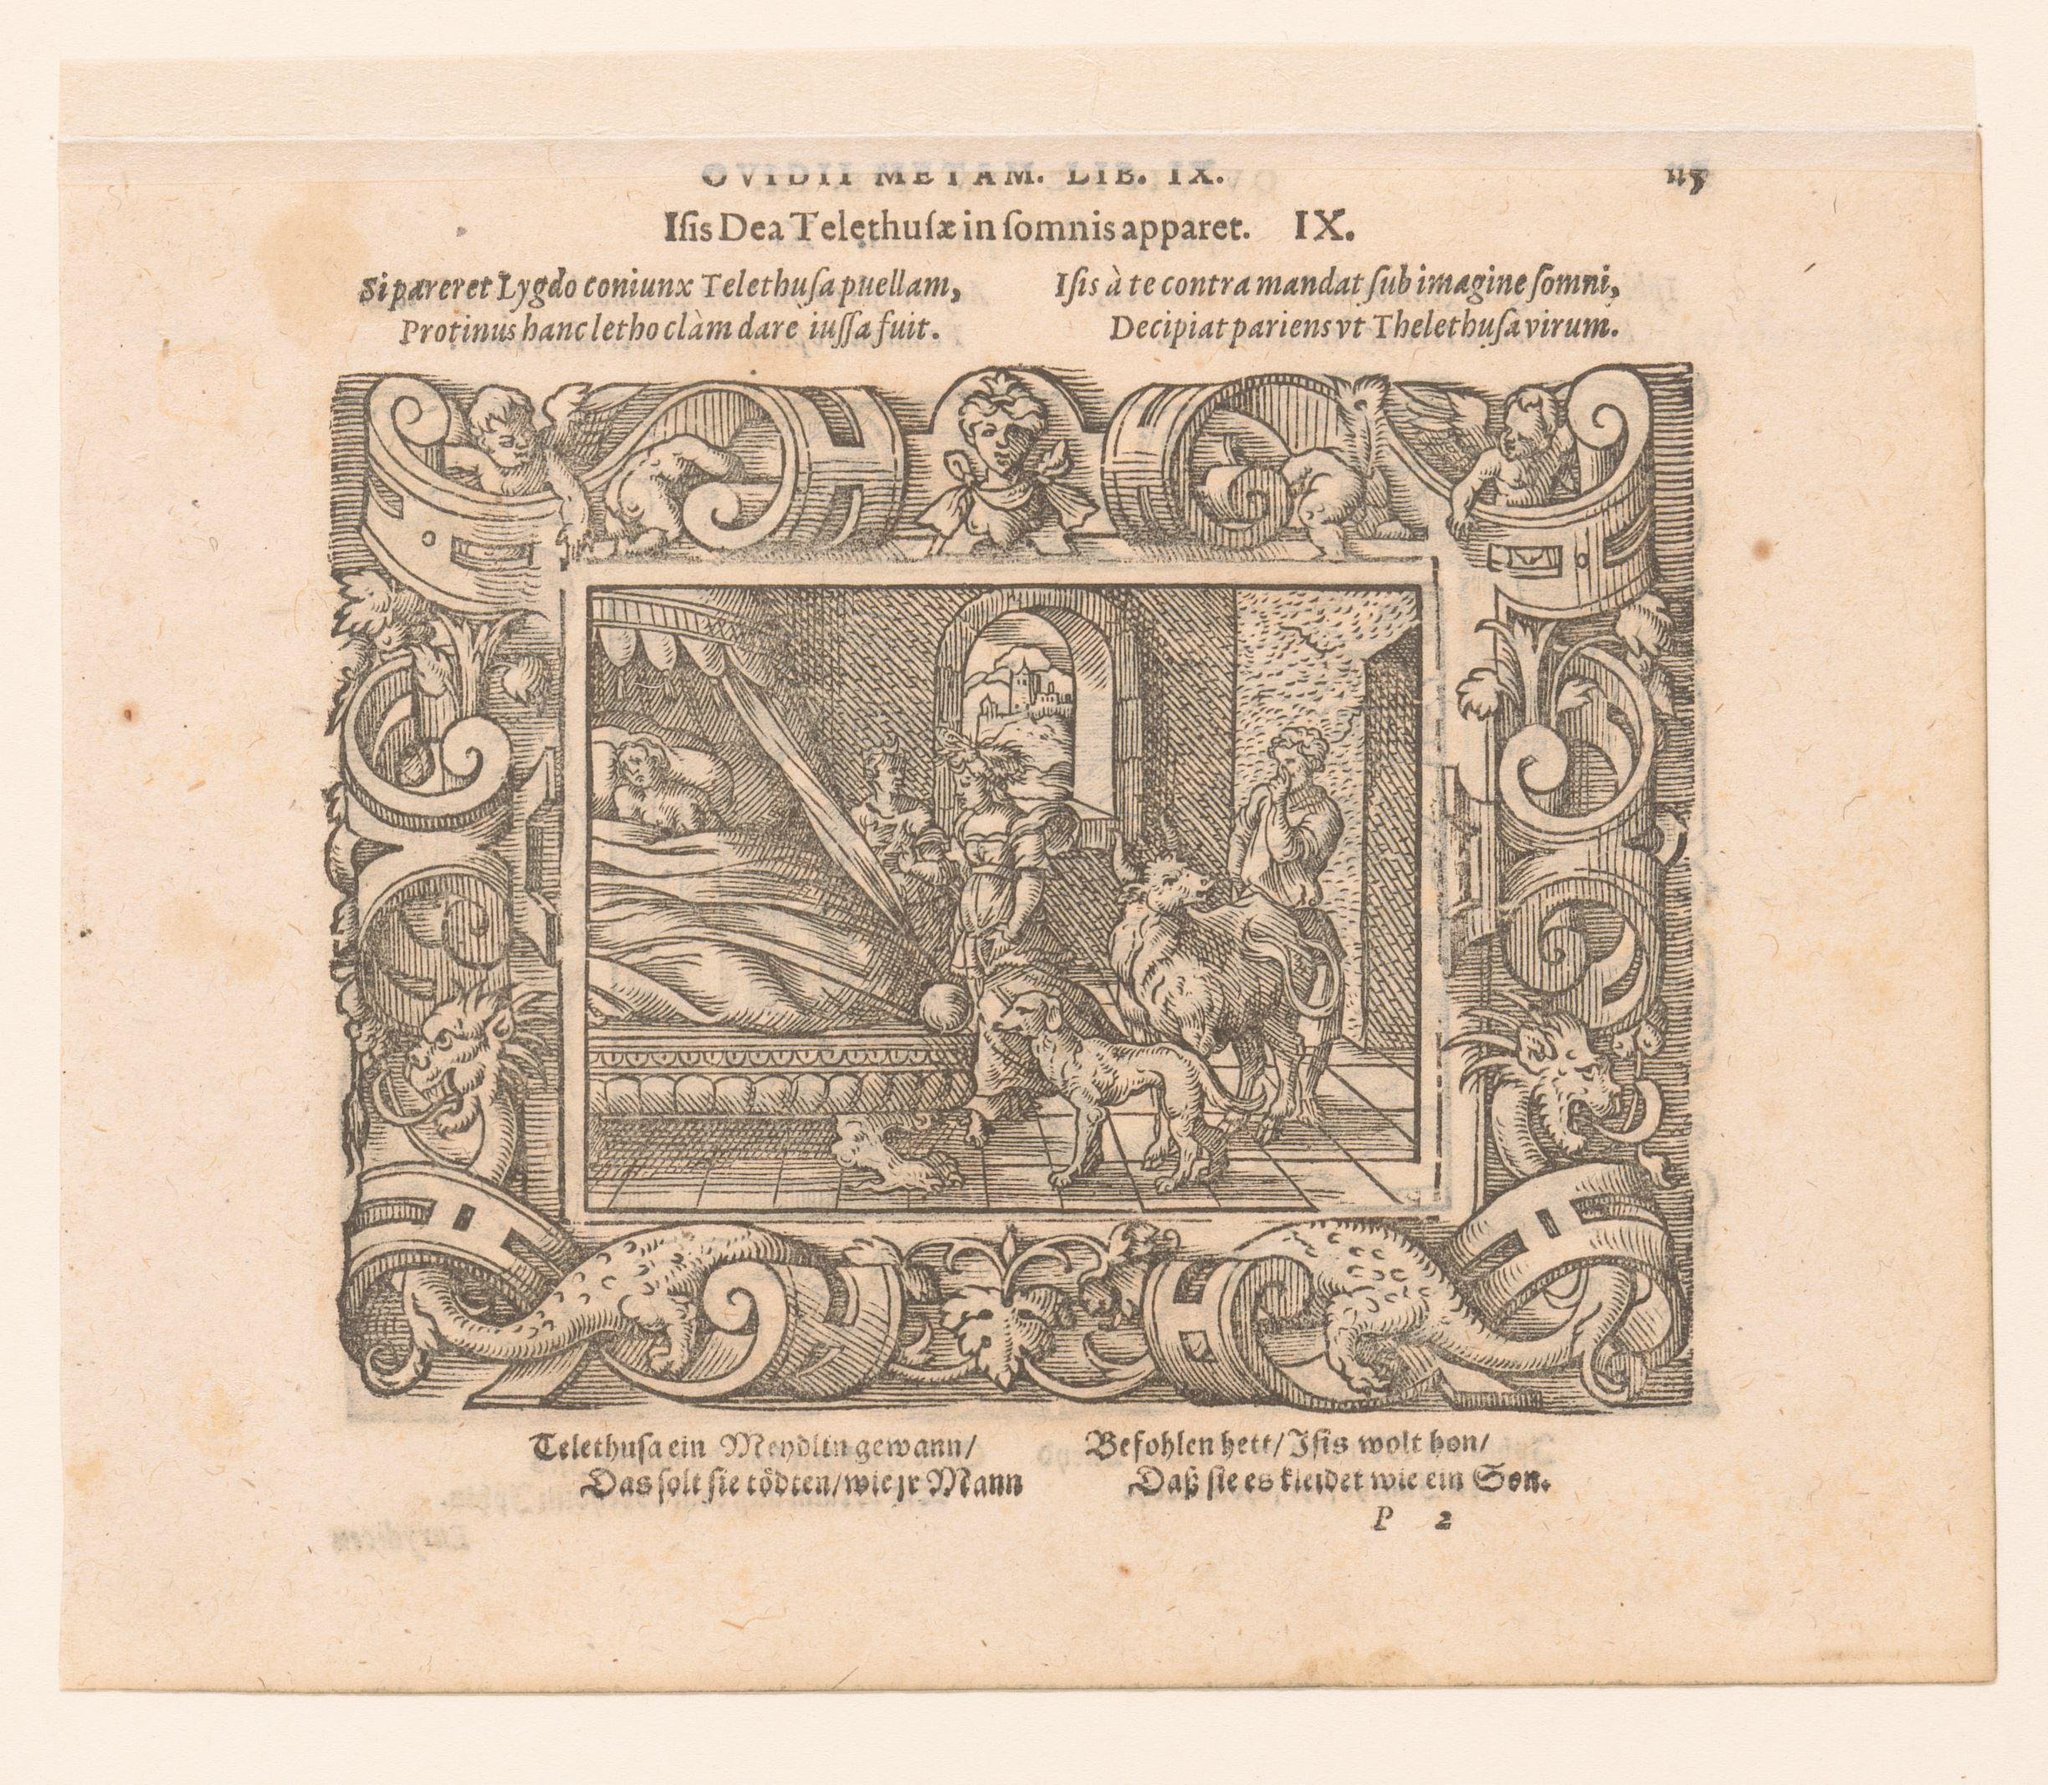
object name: print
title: Isis bezoekt Telethusa in haar droom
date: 1569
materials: paper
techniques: letterpress printing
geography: frankfurt am main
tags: scrollwork, strapwork ~ ornament, isis orders telethusa in a dream to spare the life of her child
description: Illustratie bij de Metamorfosen van Ovidius, afkomstig uit de publicatie: Posthius, Johannes. Tetrasticha in Ovidii metam. Frankfurt am Main: Georg Rab en Sigmund Feyerabend en erven Weigand Han, 1569. De voorstellingen en ornamentranden van deze boekillustraties zijn van twee aparte blokken gedrukt. Beide werden afzonderlijk van elkaar ook gebruikt voor andere publicaties, en de ornamentranden werden eveneens binnen deze publicatie meerdere keren gebruikt.